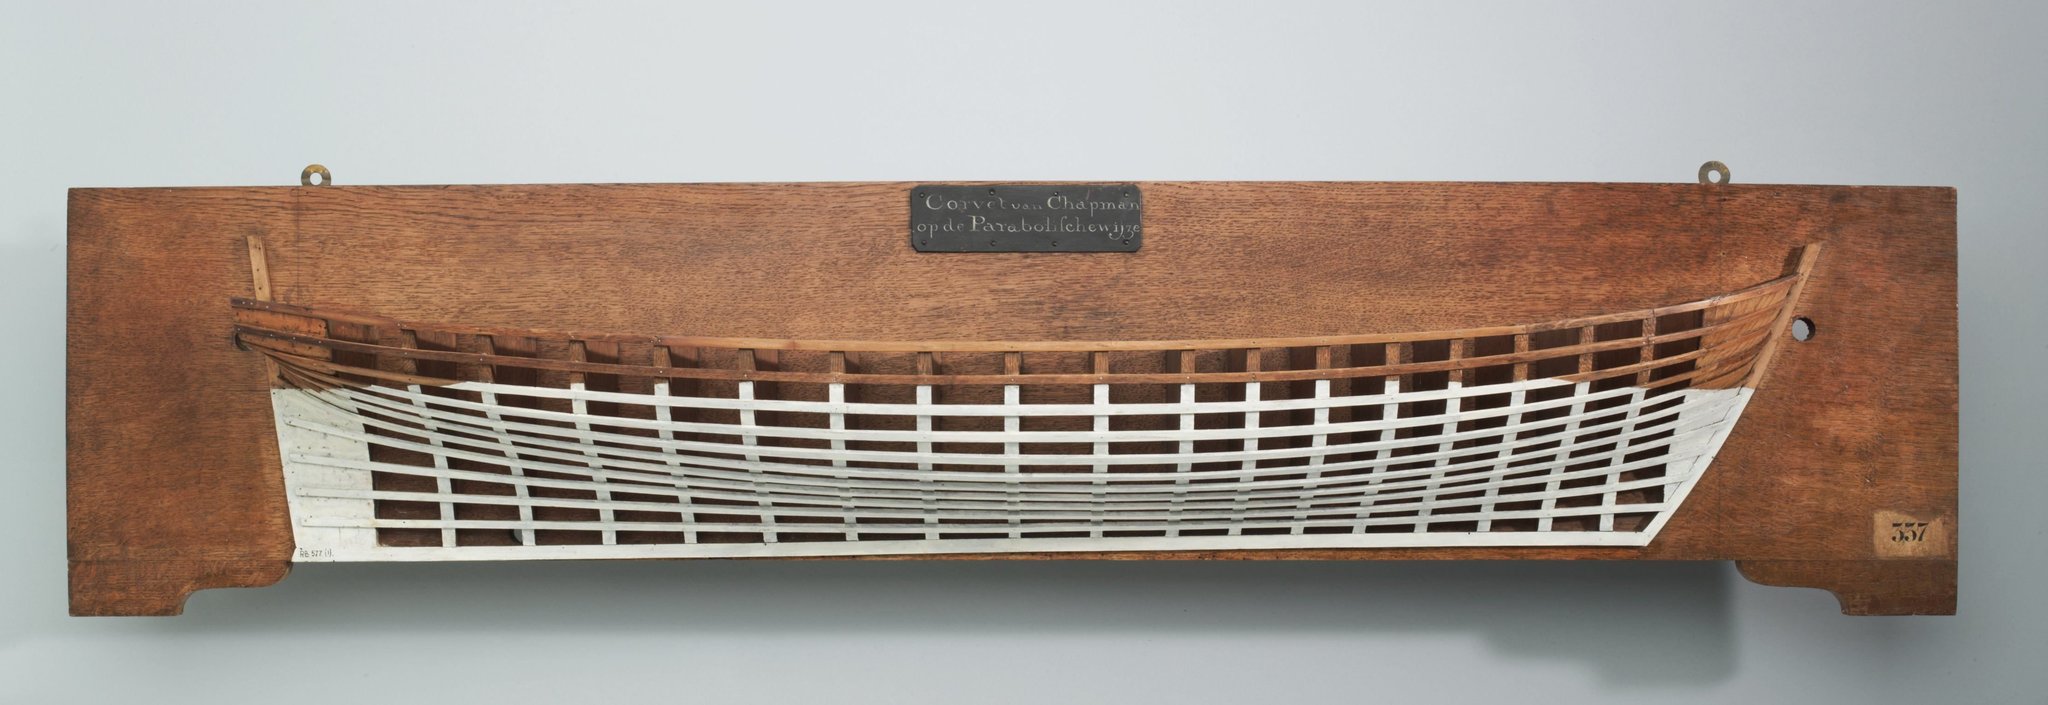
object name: ship model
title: Half Model of a Sloop of War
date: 1765-1800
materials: wood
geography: karlberg palace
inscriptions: label, bottom right: ‘337’ former inventory label, inscription, top centre, on a rectangular black label: ‘Corvet van CHAPMAN op de parabolische wijze’, inscription, on the skeg of the keel: ‘RB.577(1)’ former inventory marking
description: Mallenmodel (stuurboord), zonder details of tuigaanduiding. Opvallend aan dit model is de sterk vallende voorsteven. Geen geschutpoorten of dekken aangegeven. Gewrongen spiegel, geen wulf, hek, zijgalerij of roer aangegeven. Zeeg naar achter en voor oplopend, geen barkhouten aangegeven. Gepiekt rondspant.